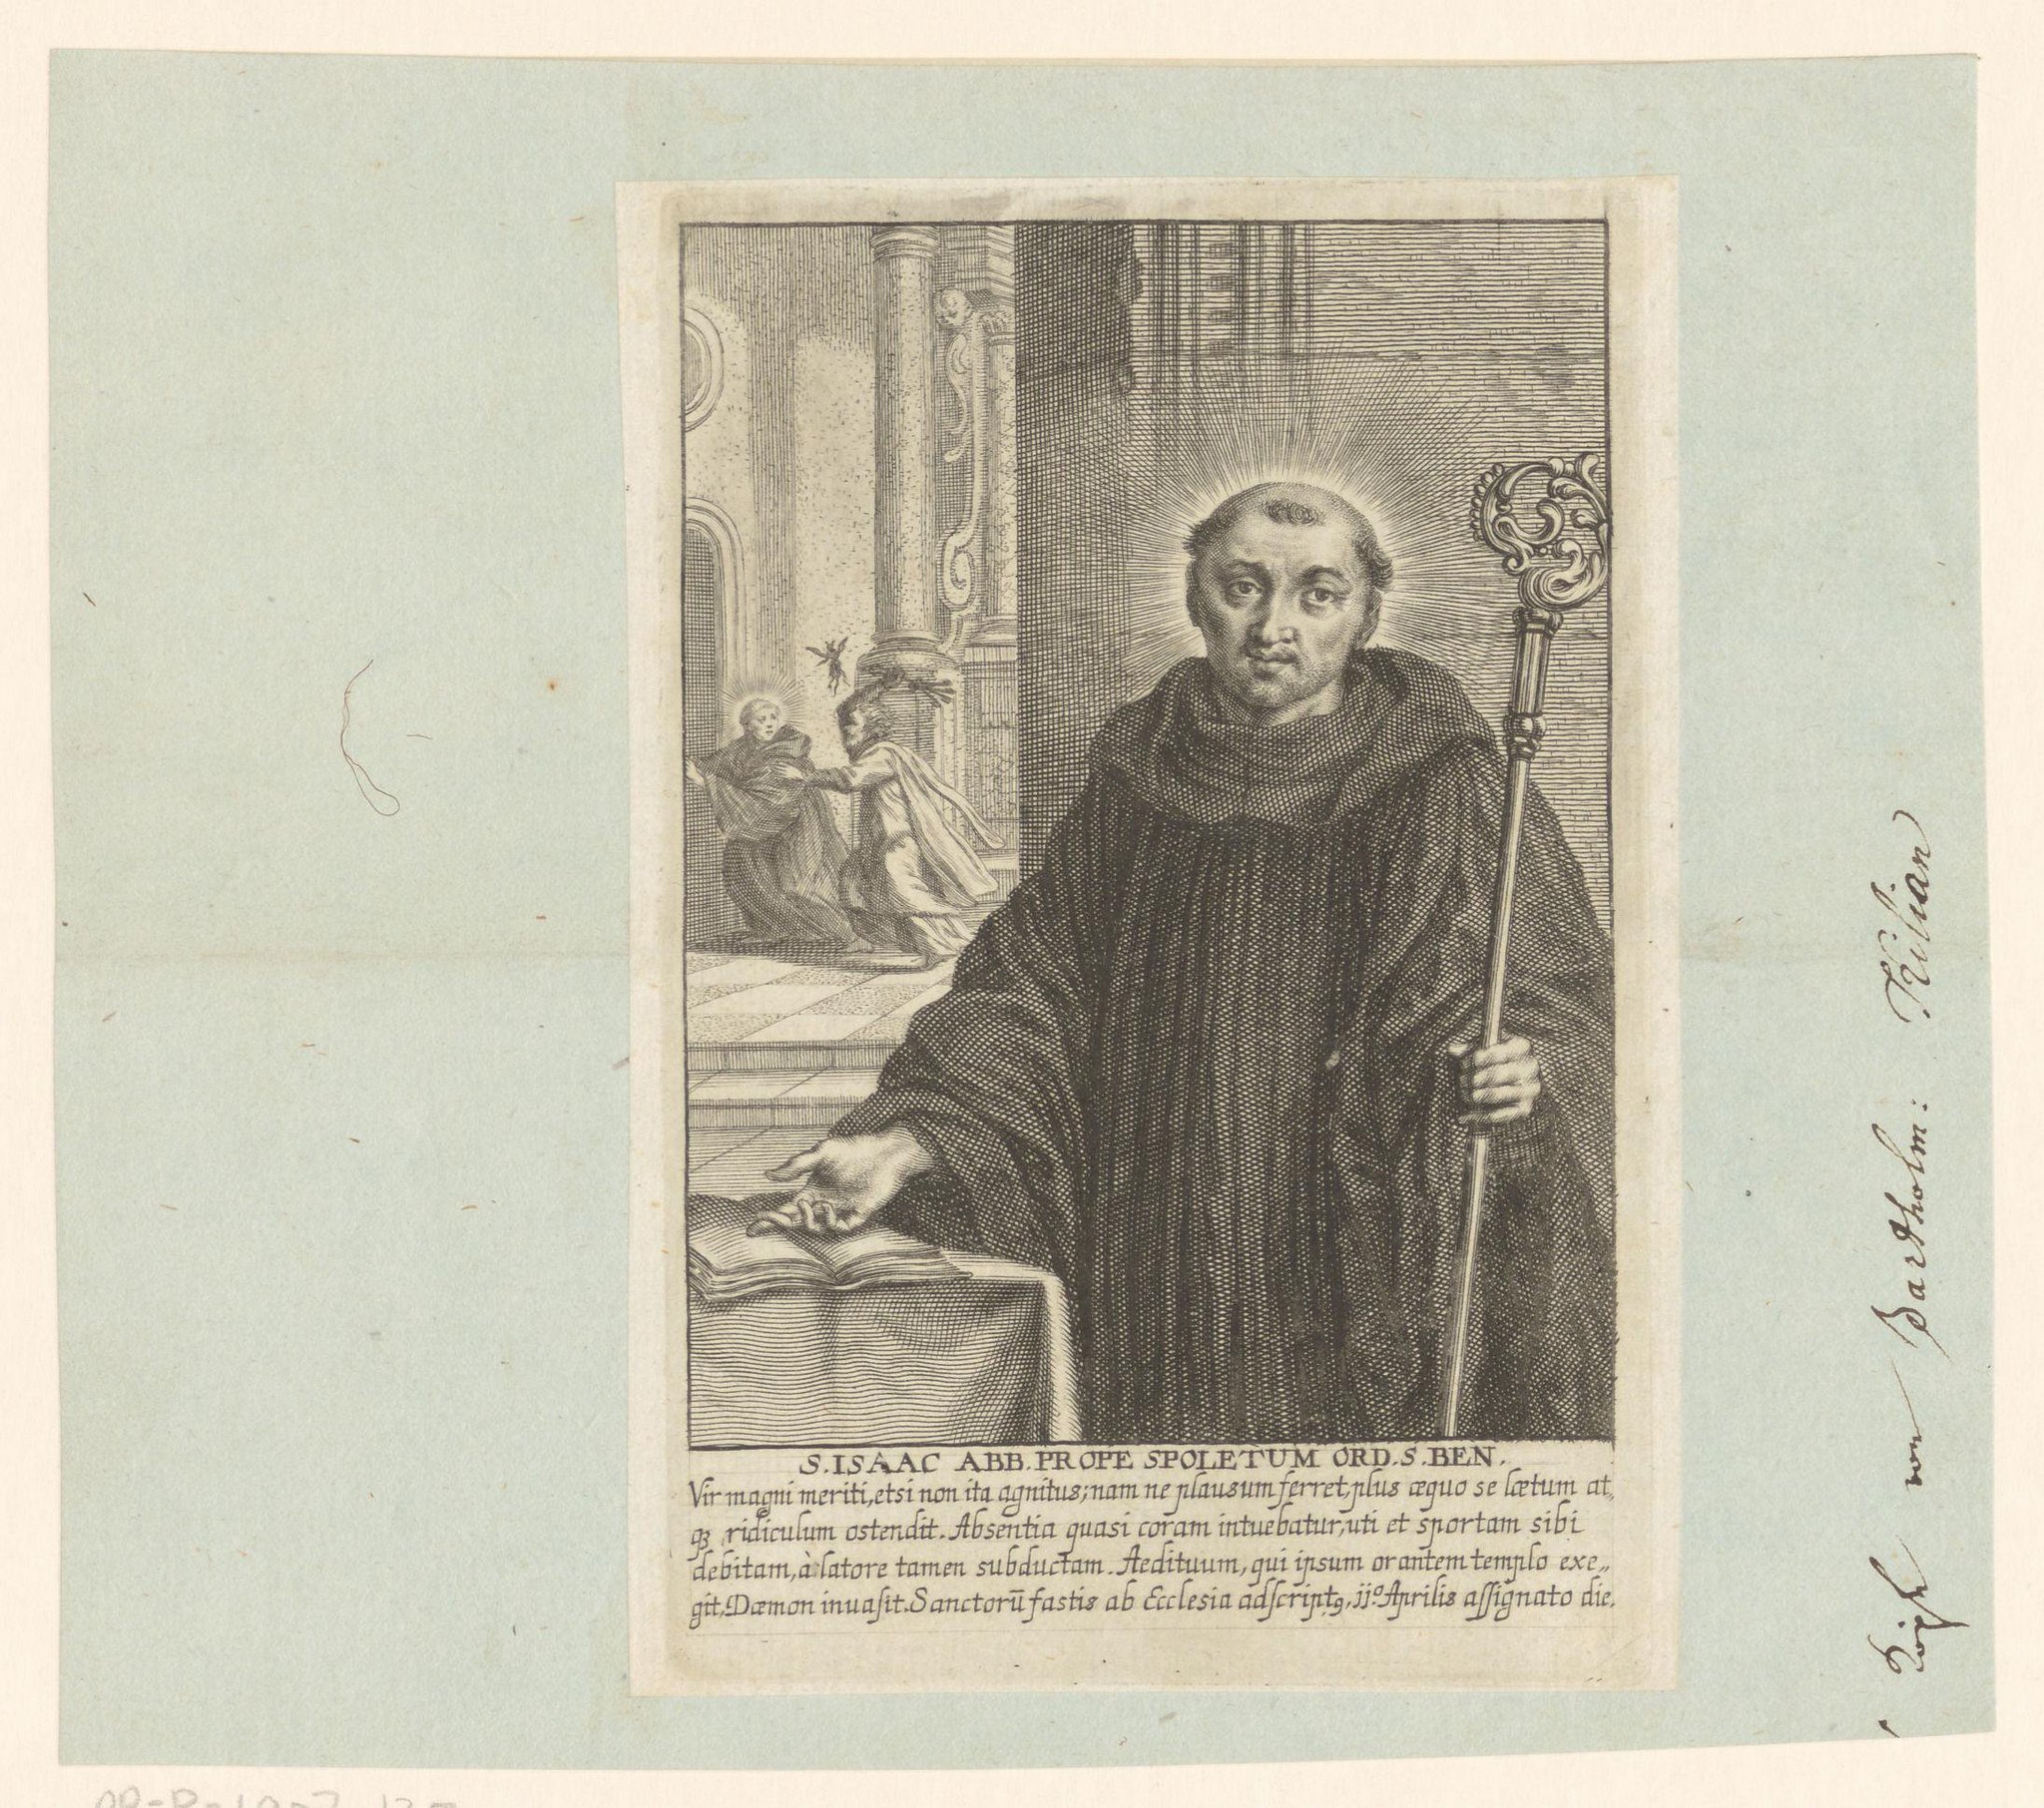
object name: print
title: H. Isaac met staf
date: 1640-1696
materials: paper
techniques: engraving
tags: saints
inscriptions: collector's mark: Lugt 2228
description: In de marge onderaan vier regels tekst in het Latijn over deze Benedictijner monnik.